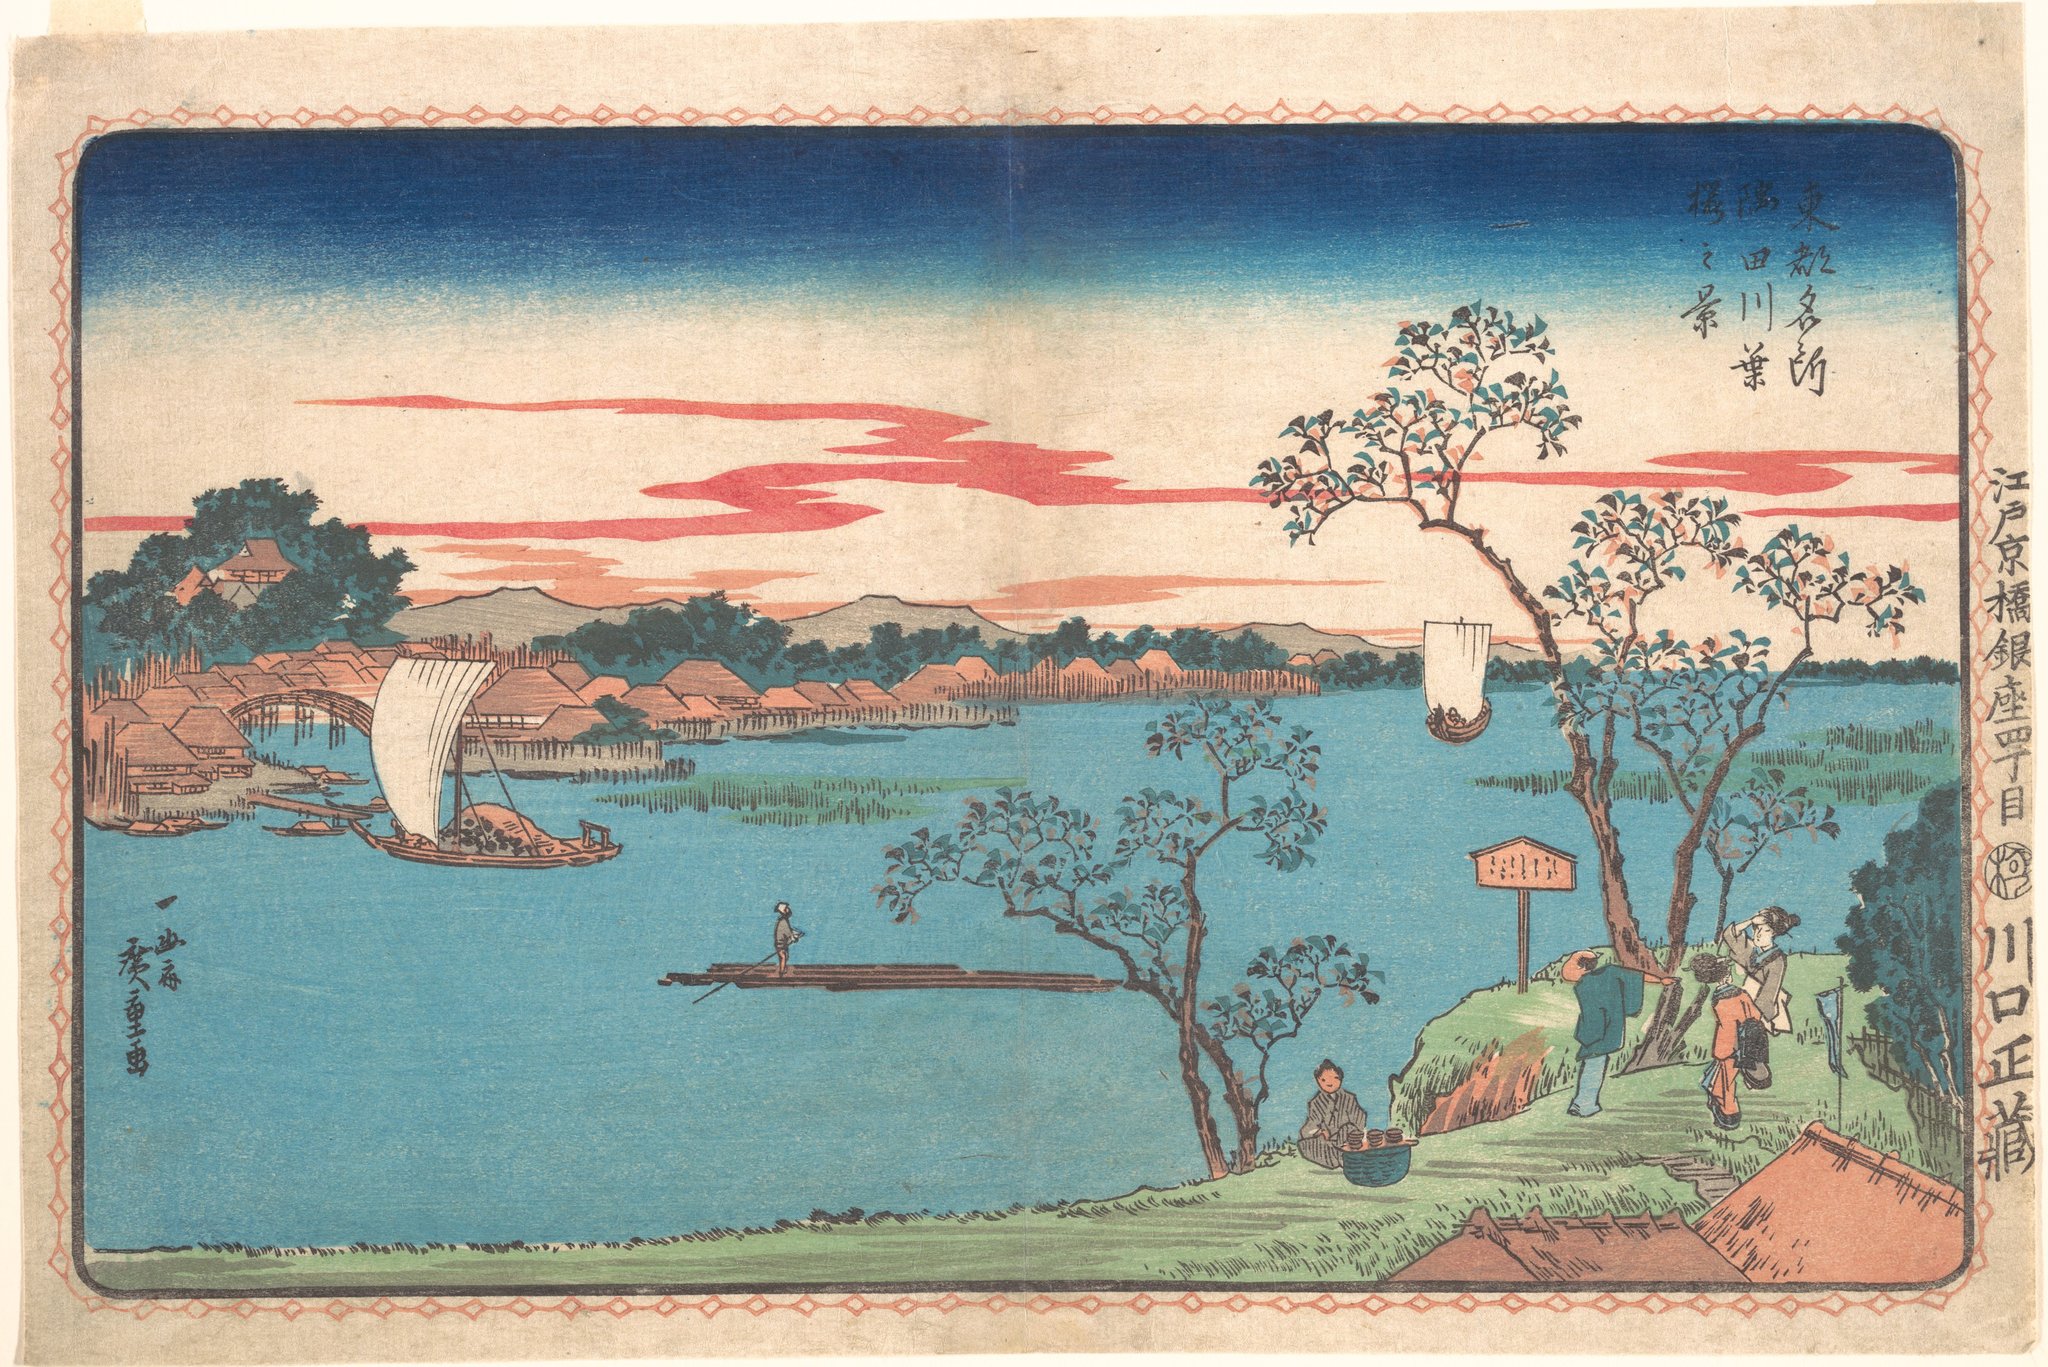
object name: print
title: A View of Cherry Trees in Leaf along the Sumida River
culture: japanese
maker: utagawa hiroshige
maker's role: artist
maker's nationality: japanese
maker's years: 1797-1858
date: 1831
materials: ink, paper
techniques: woodblock print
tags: human figures,houses,rivers,trees,boats